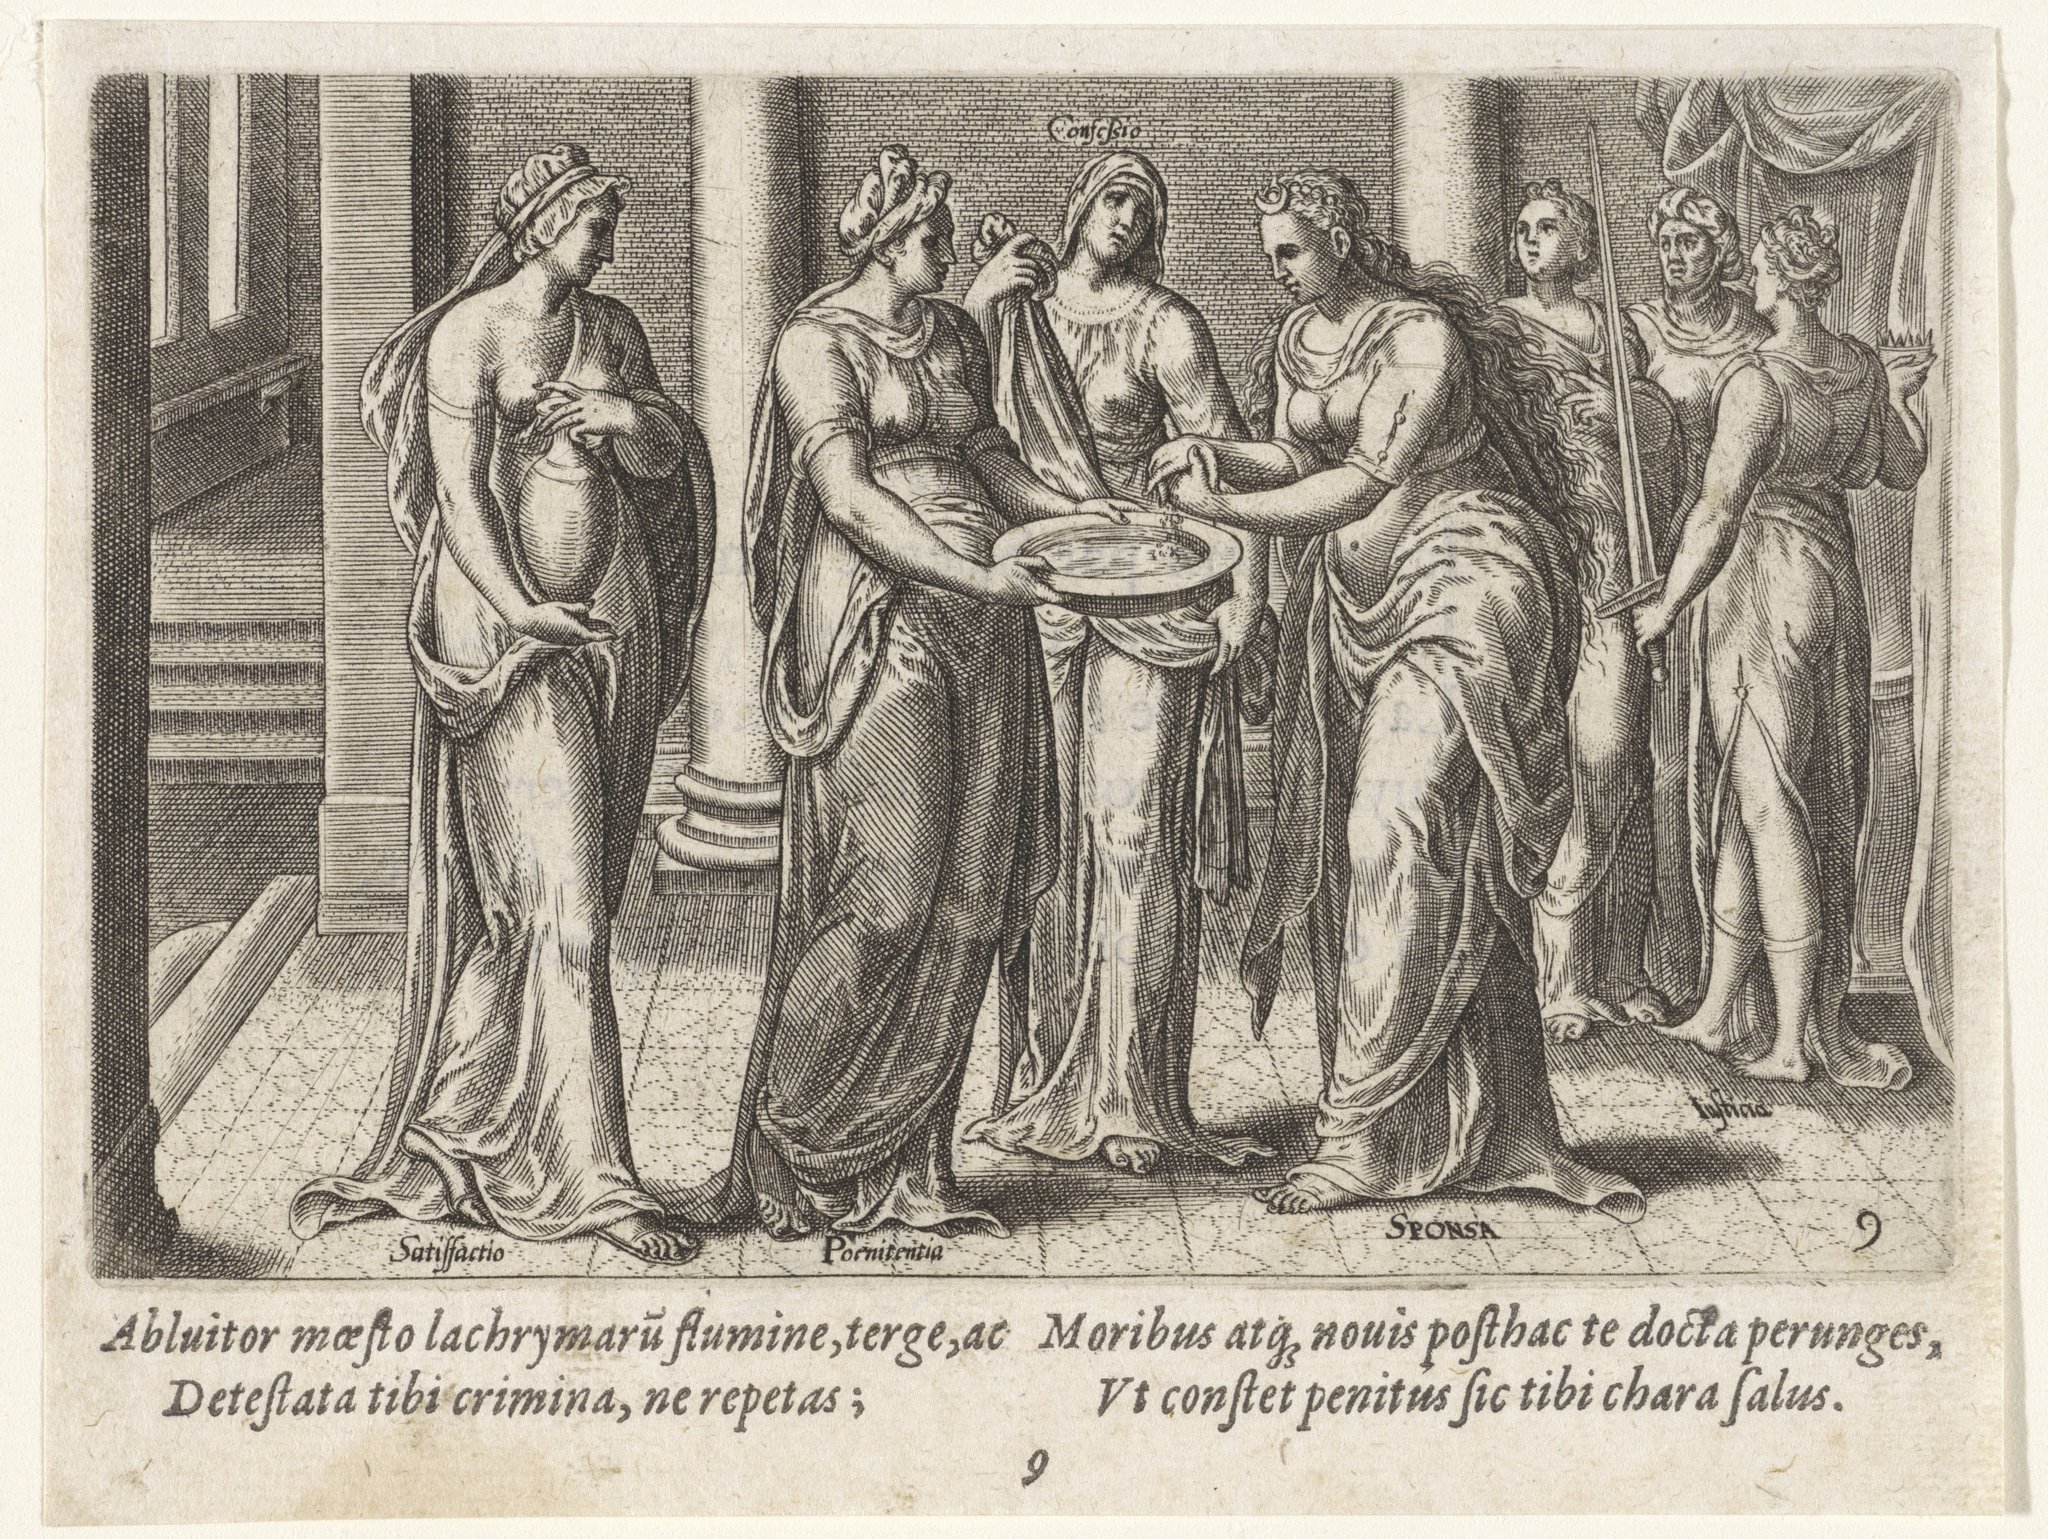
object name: print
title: De boetvaardige bruid wast haar handen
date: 1574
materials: paper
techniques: engraving, letterpress printing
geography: antwerp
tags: satisfaction, contentment; 'contento' (ripa), justice, 'justitia'; 'giustitia divina' (ripa) ~ one of the four cardinal virtues, castigation, flagellation ~ ascetic life (+ variant), confession; 'confessione sacramentale' (ripa) ~ the third of the seven sacraments, bride (in wedding-dress), piety, 'pietas', 'timor dei' ~ the three theological virtues, washing one's hands, penance, 'poenitentia'; 'contritione' (ripa) ~ part of the confession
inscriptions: collector's mark: Lugt 2228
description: De boetvaardige bruid (Sponsa) wast haar handen in een schaal die door Boetvaardigheid (Poenitentia) wordt vastgehouden. Biecht (Confessio) en Voldoening (Satisfactio) kijken toe. Op de achtergrond Rechtvaardigheid (Justitia), Kastijding (Castigatio) en Godsvrucht (Timor Dei). In de marge een vierregelig onderschrift, in twee kolommen, in het Latijn.